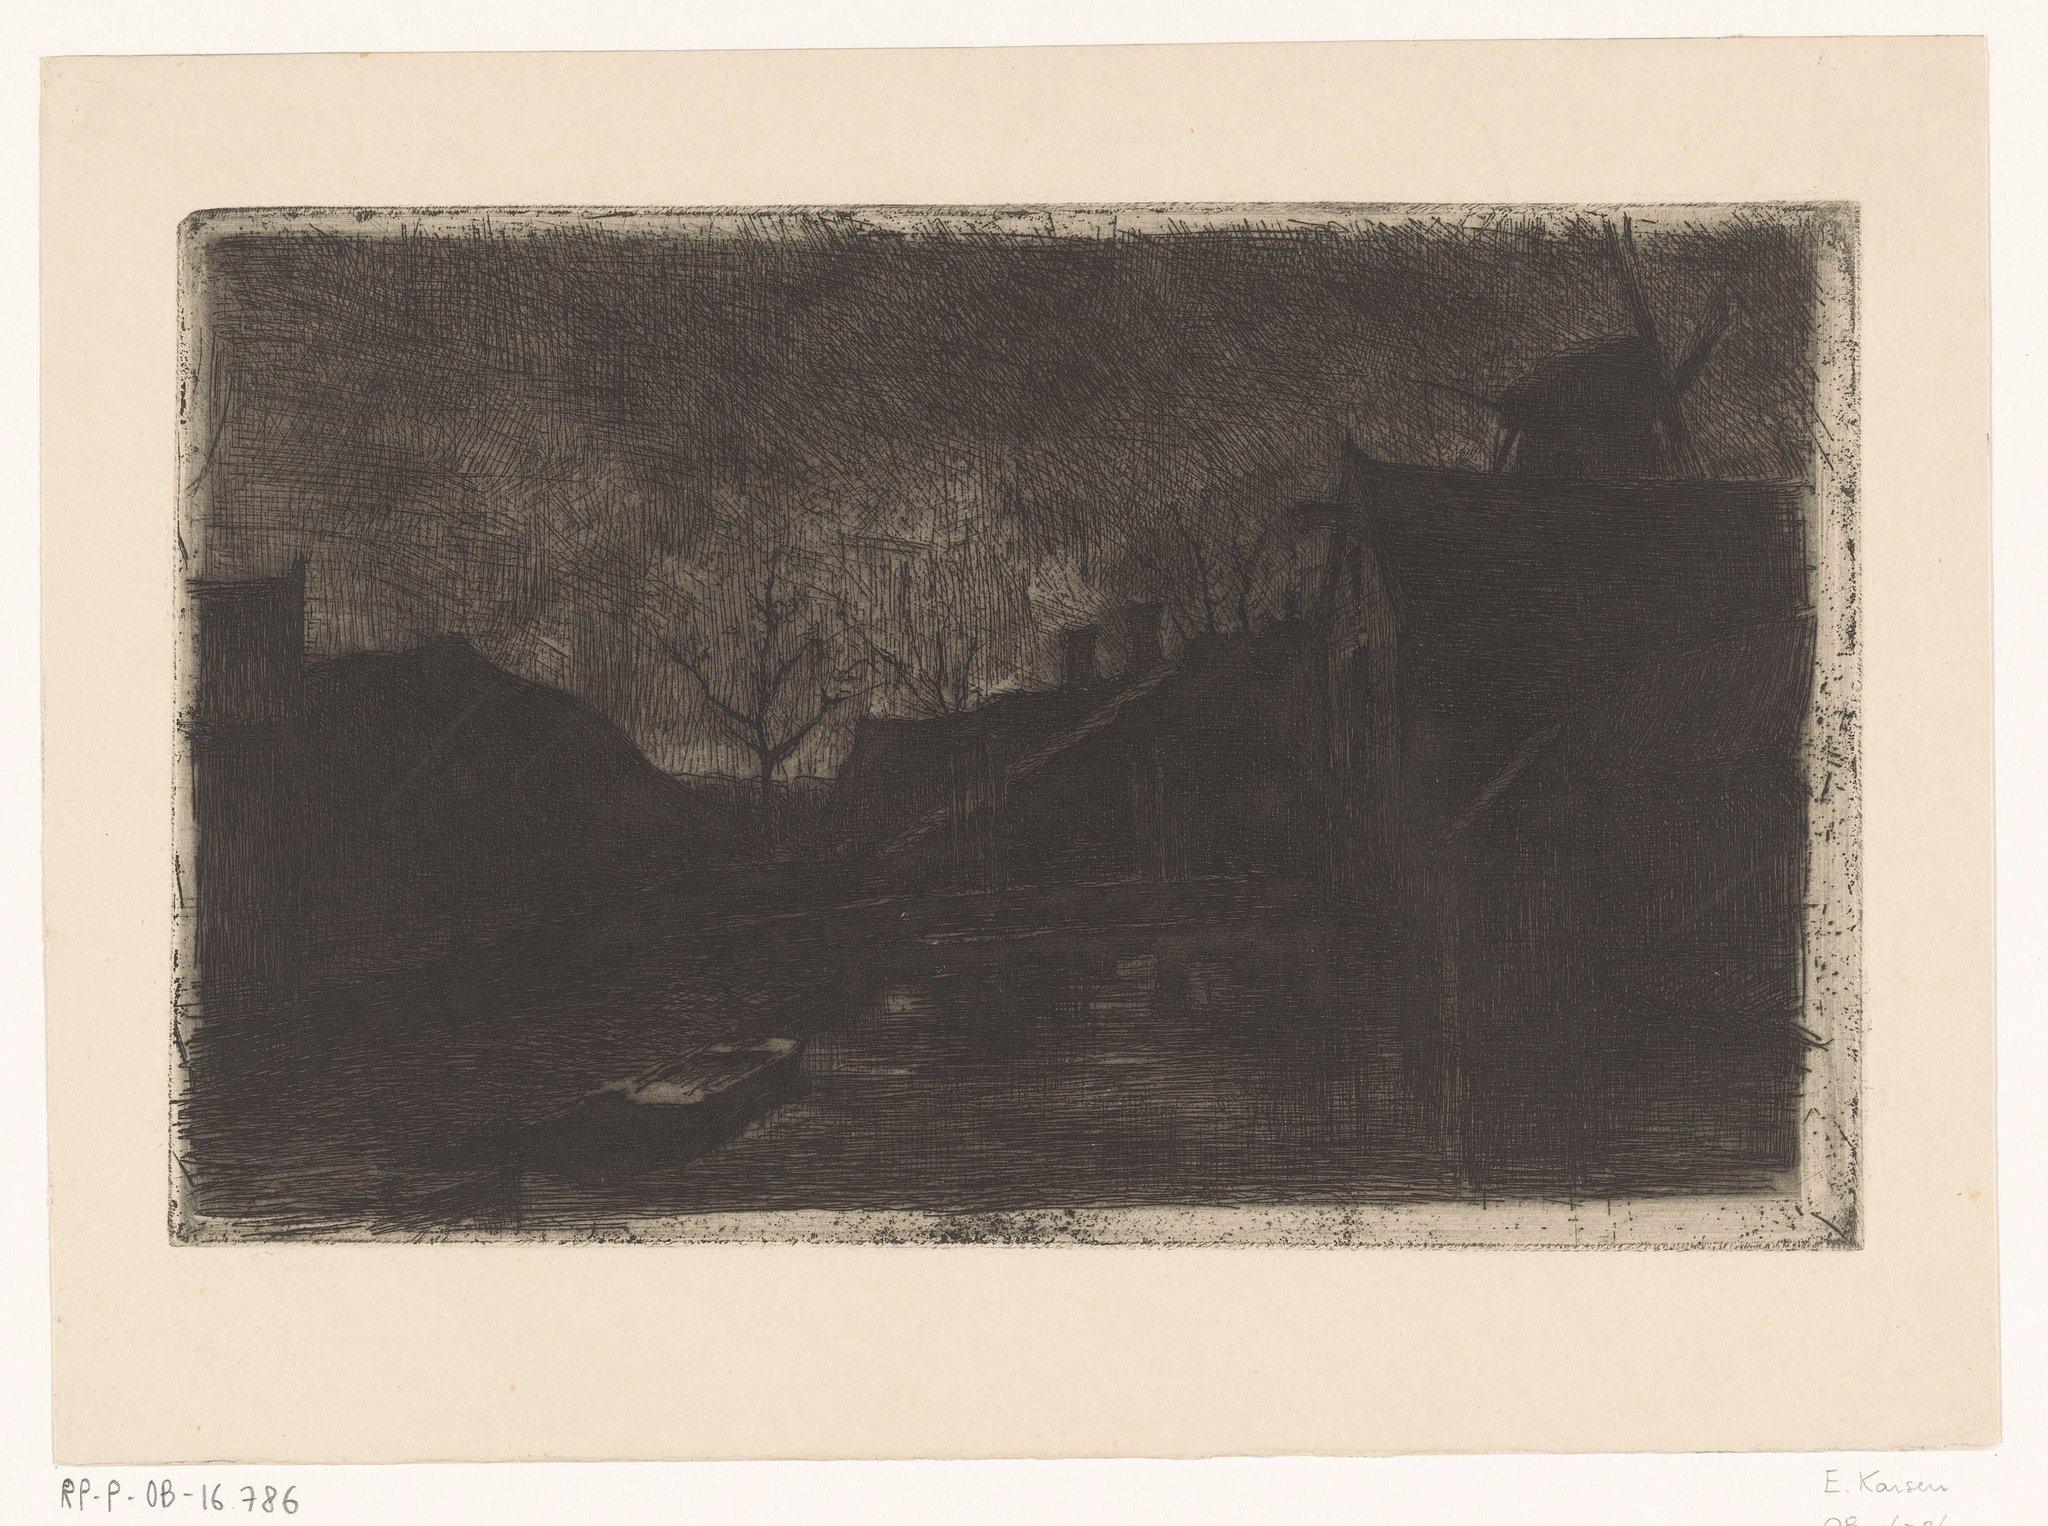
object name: print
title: Landschap met huizen en molen bij avond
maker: eduard karsen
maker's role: draughtsman, painter, print maker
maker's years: 1860-1941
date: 1870-1941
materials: paper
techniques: etching, intaglio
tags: evening, windmill in landscape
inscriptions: collector's mark: Lugt 2228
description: Prent afkomstig uit de Portefeuille der Nederlandsche Etsclub, derde jaargang, 1888.